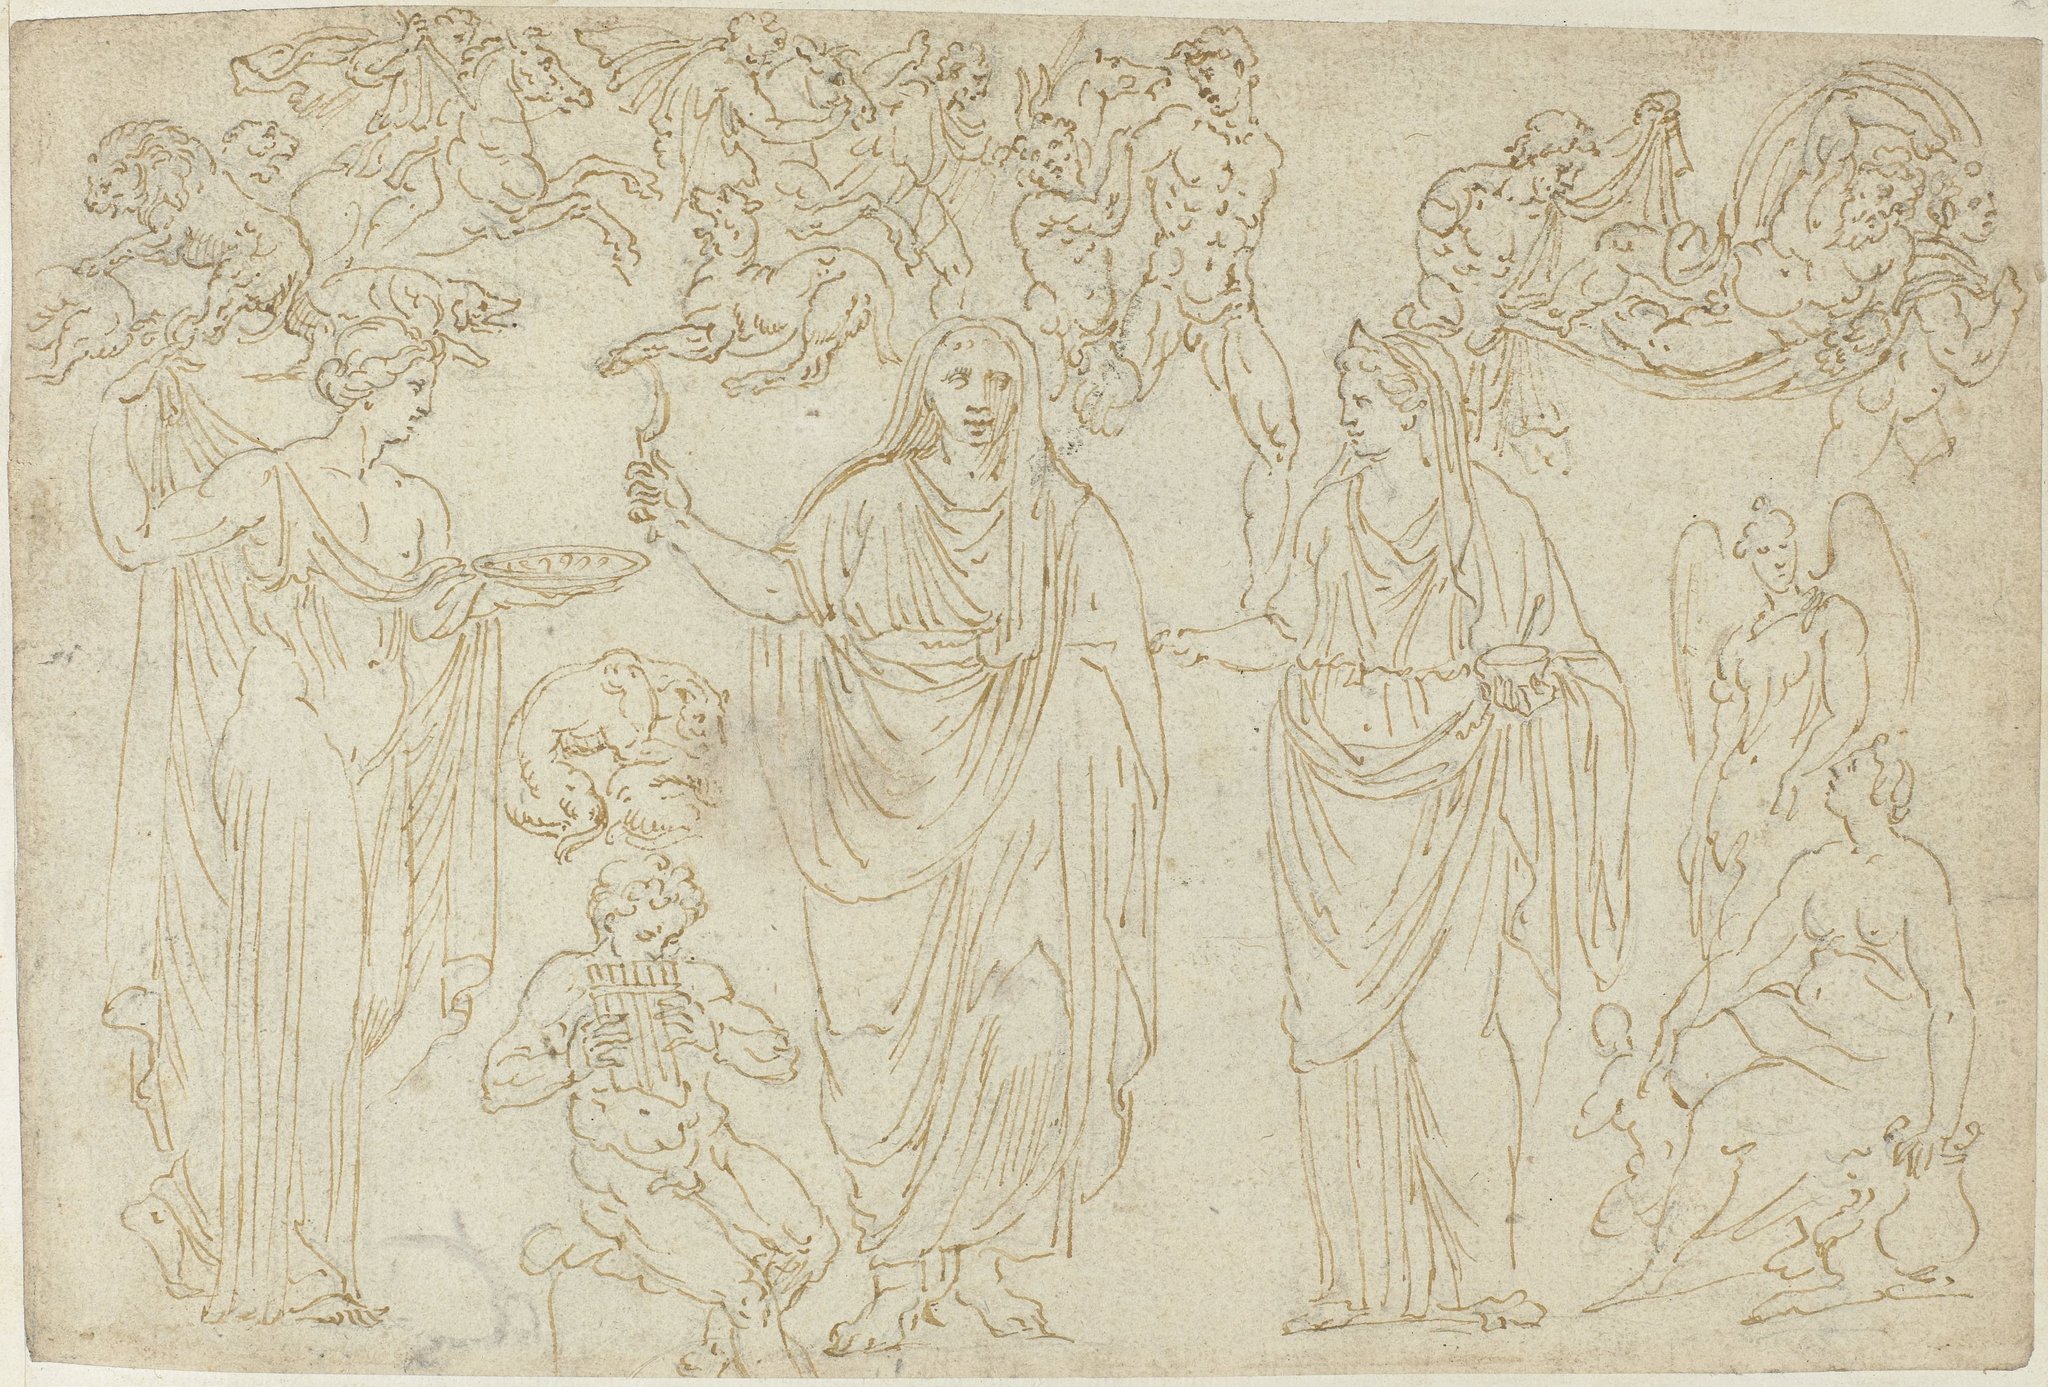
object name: drawing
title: Sculptuur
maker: Anonymous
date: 1550-1570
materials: chalk, ink, paper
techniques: pen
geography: low countries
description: Album "Maarten de Vos schetsboek", blad 1v(12)